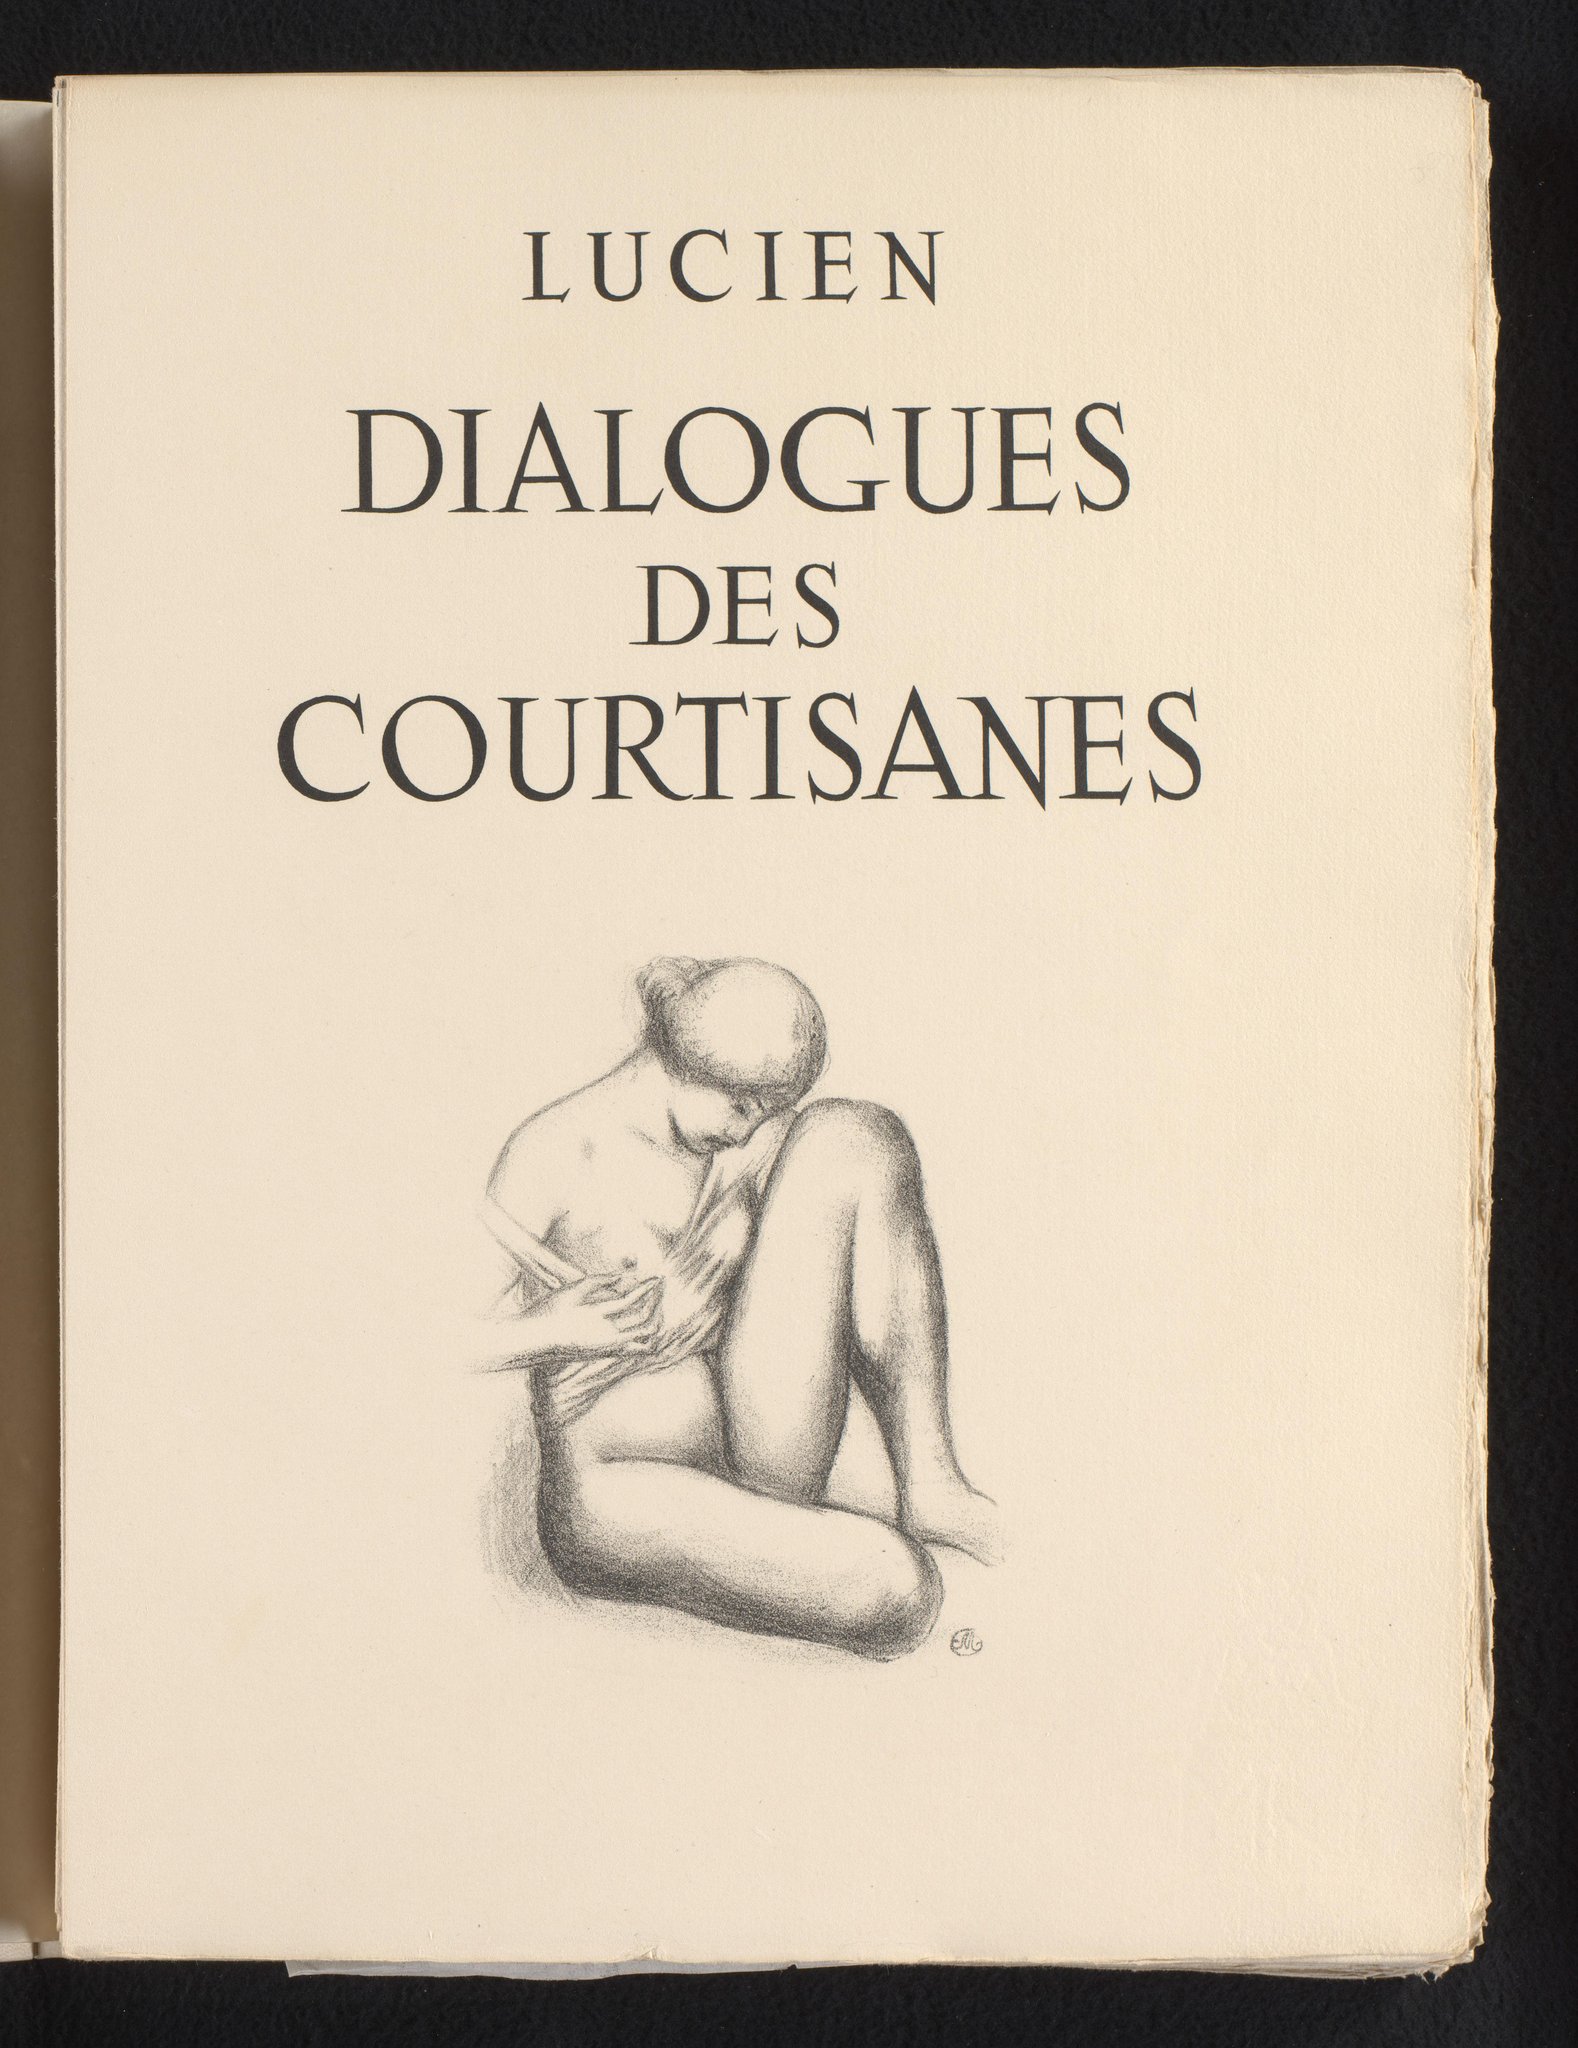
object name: titelblad, titelpagina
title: Lucien dialogues des courtisanes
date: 1948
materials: paper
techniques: letterpress printing, lithograph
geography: paris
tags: sitting figure - aa - female human figure, title-page, woman (showing herself) undressed, quasi-nude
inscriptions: collector's mark: Lugt 2166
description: Titelpagina uit: Lucianus van Samosata. Dialogues des Courtisanes. [Vertaald uit het Grieks door] Charles Astruc. Parijs: s.n., 1948.